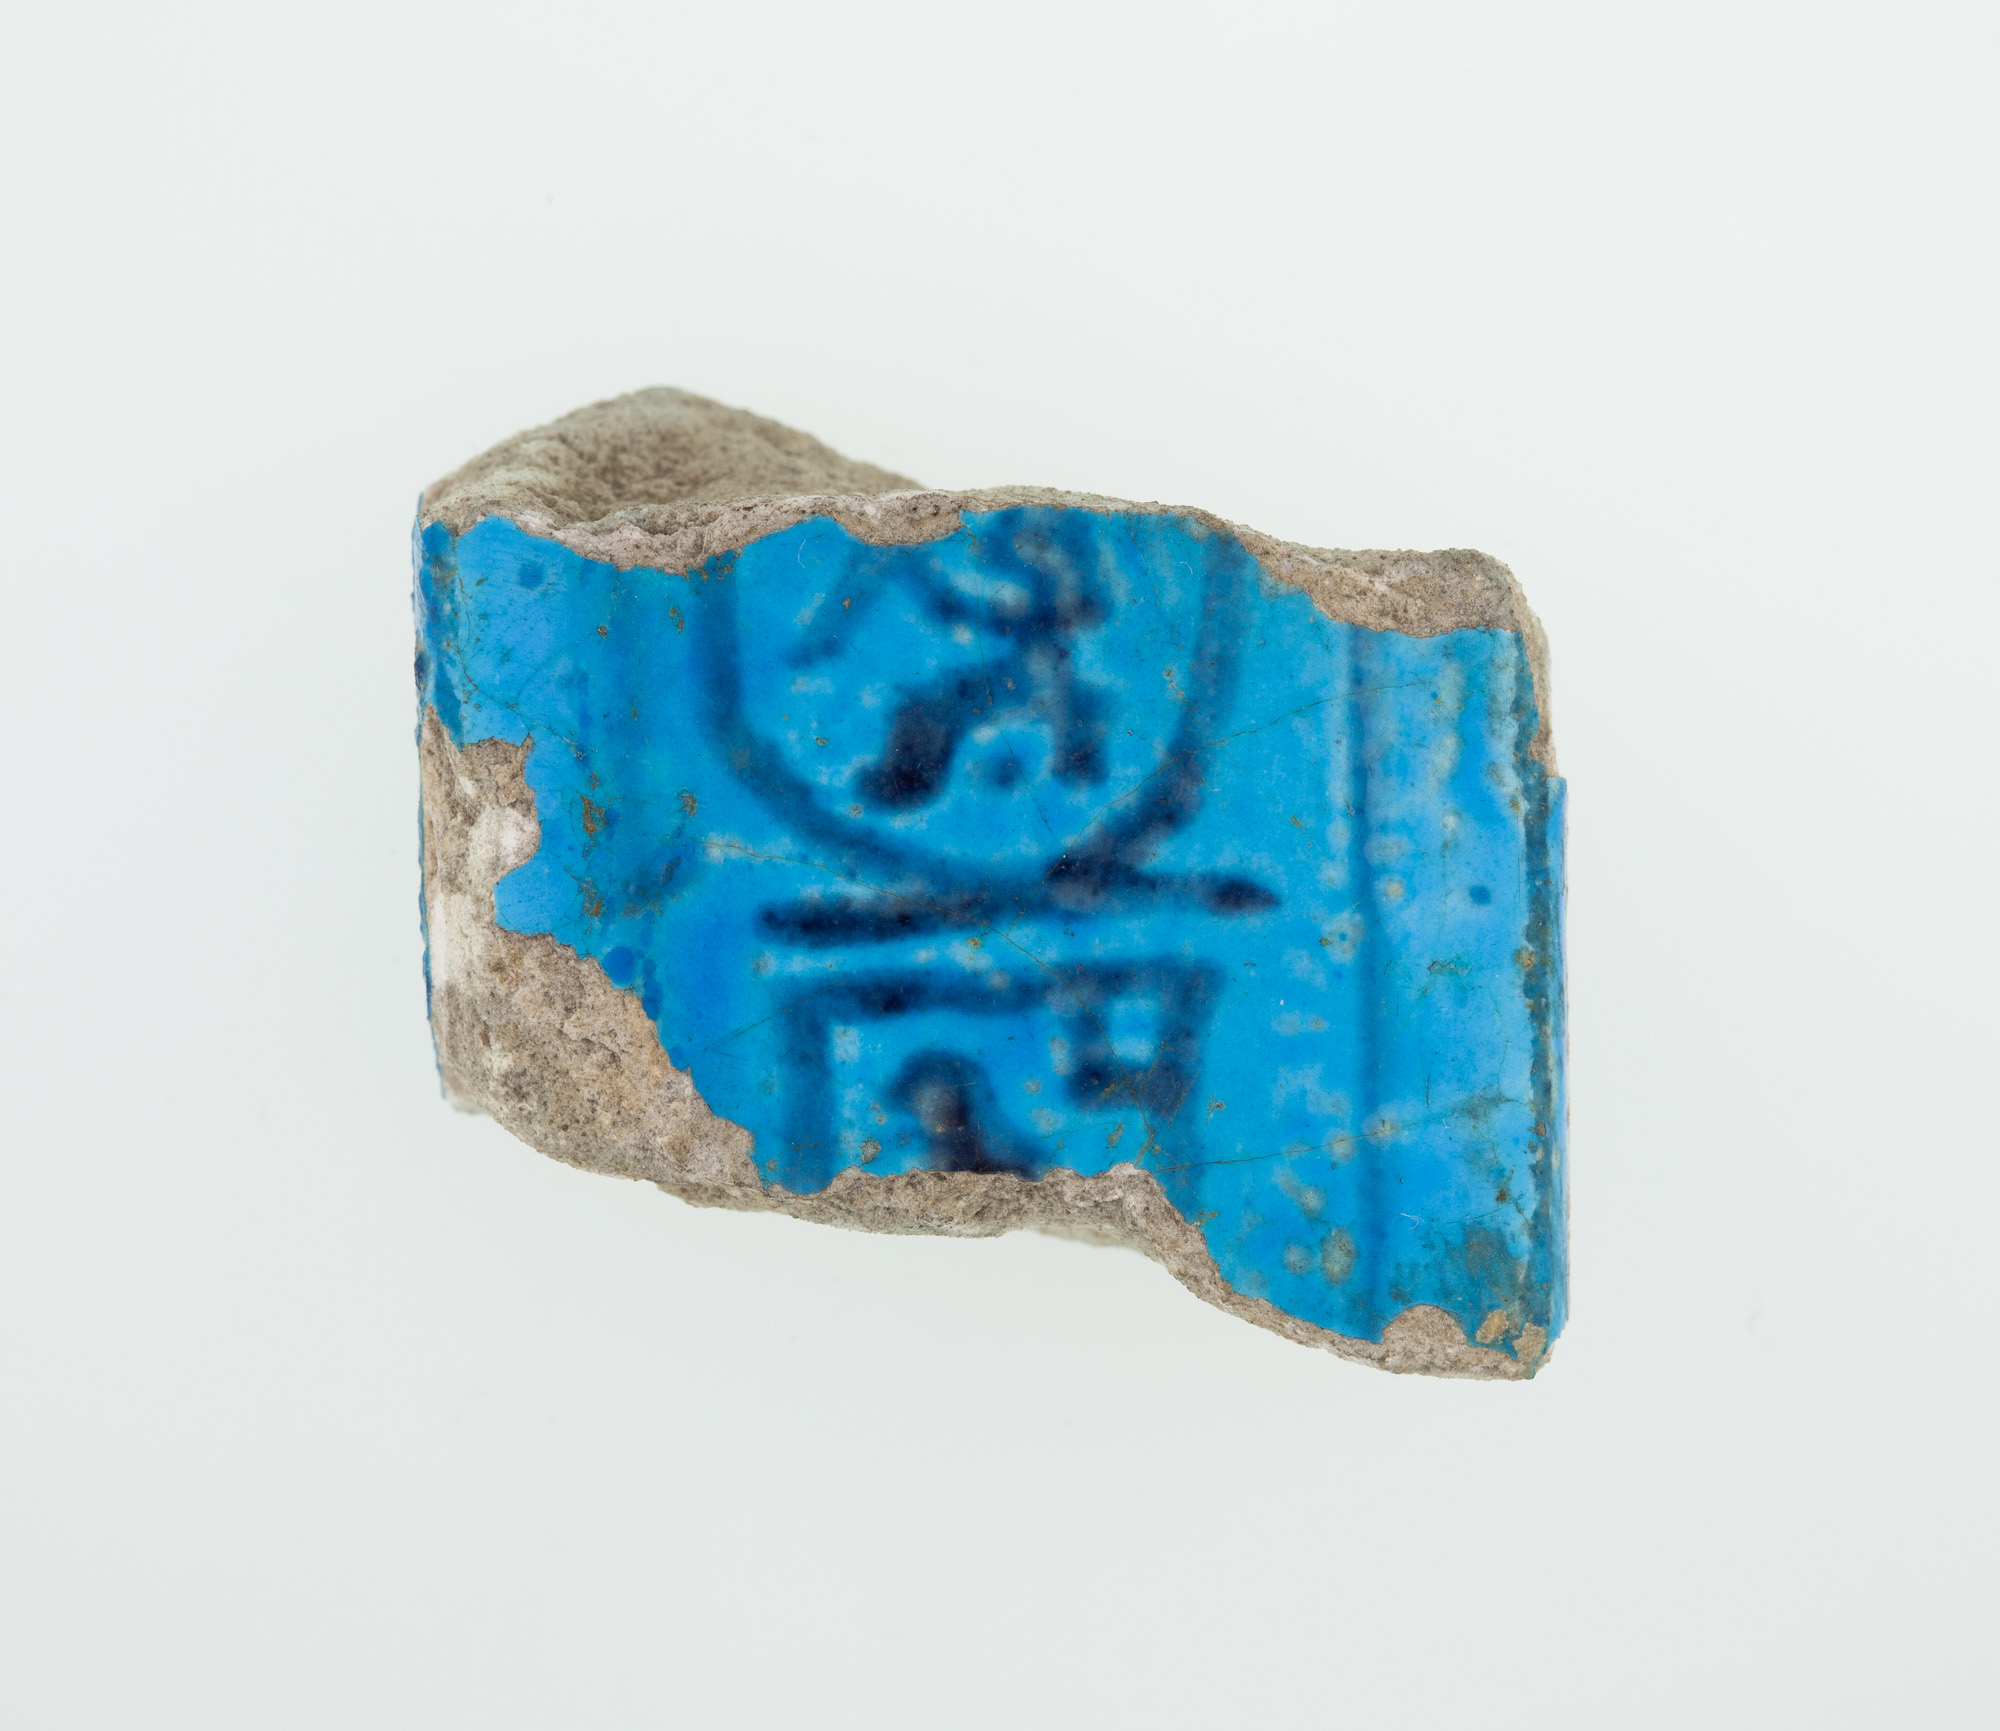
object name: menat fragment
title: Fragment of a Menat Counterpoise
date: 1479-1458 BCE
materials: faience, paint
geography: egypt